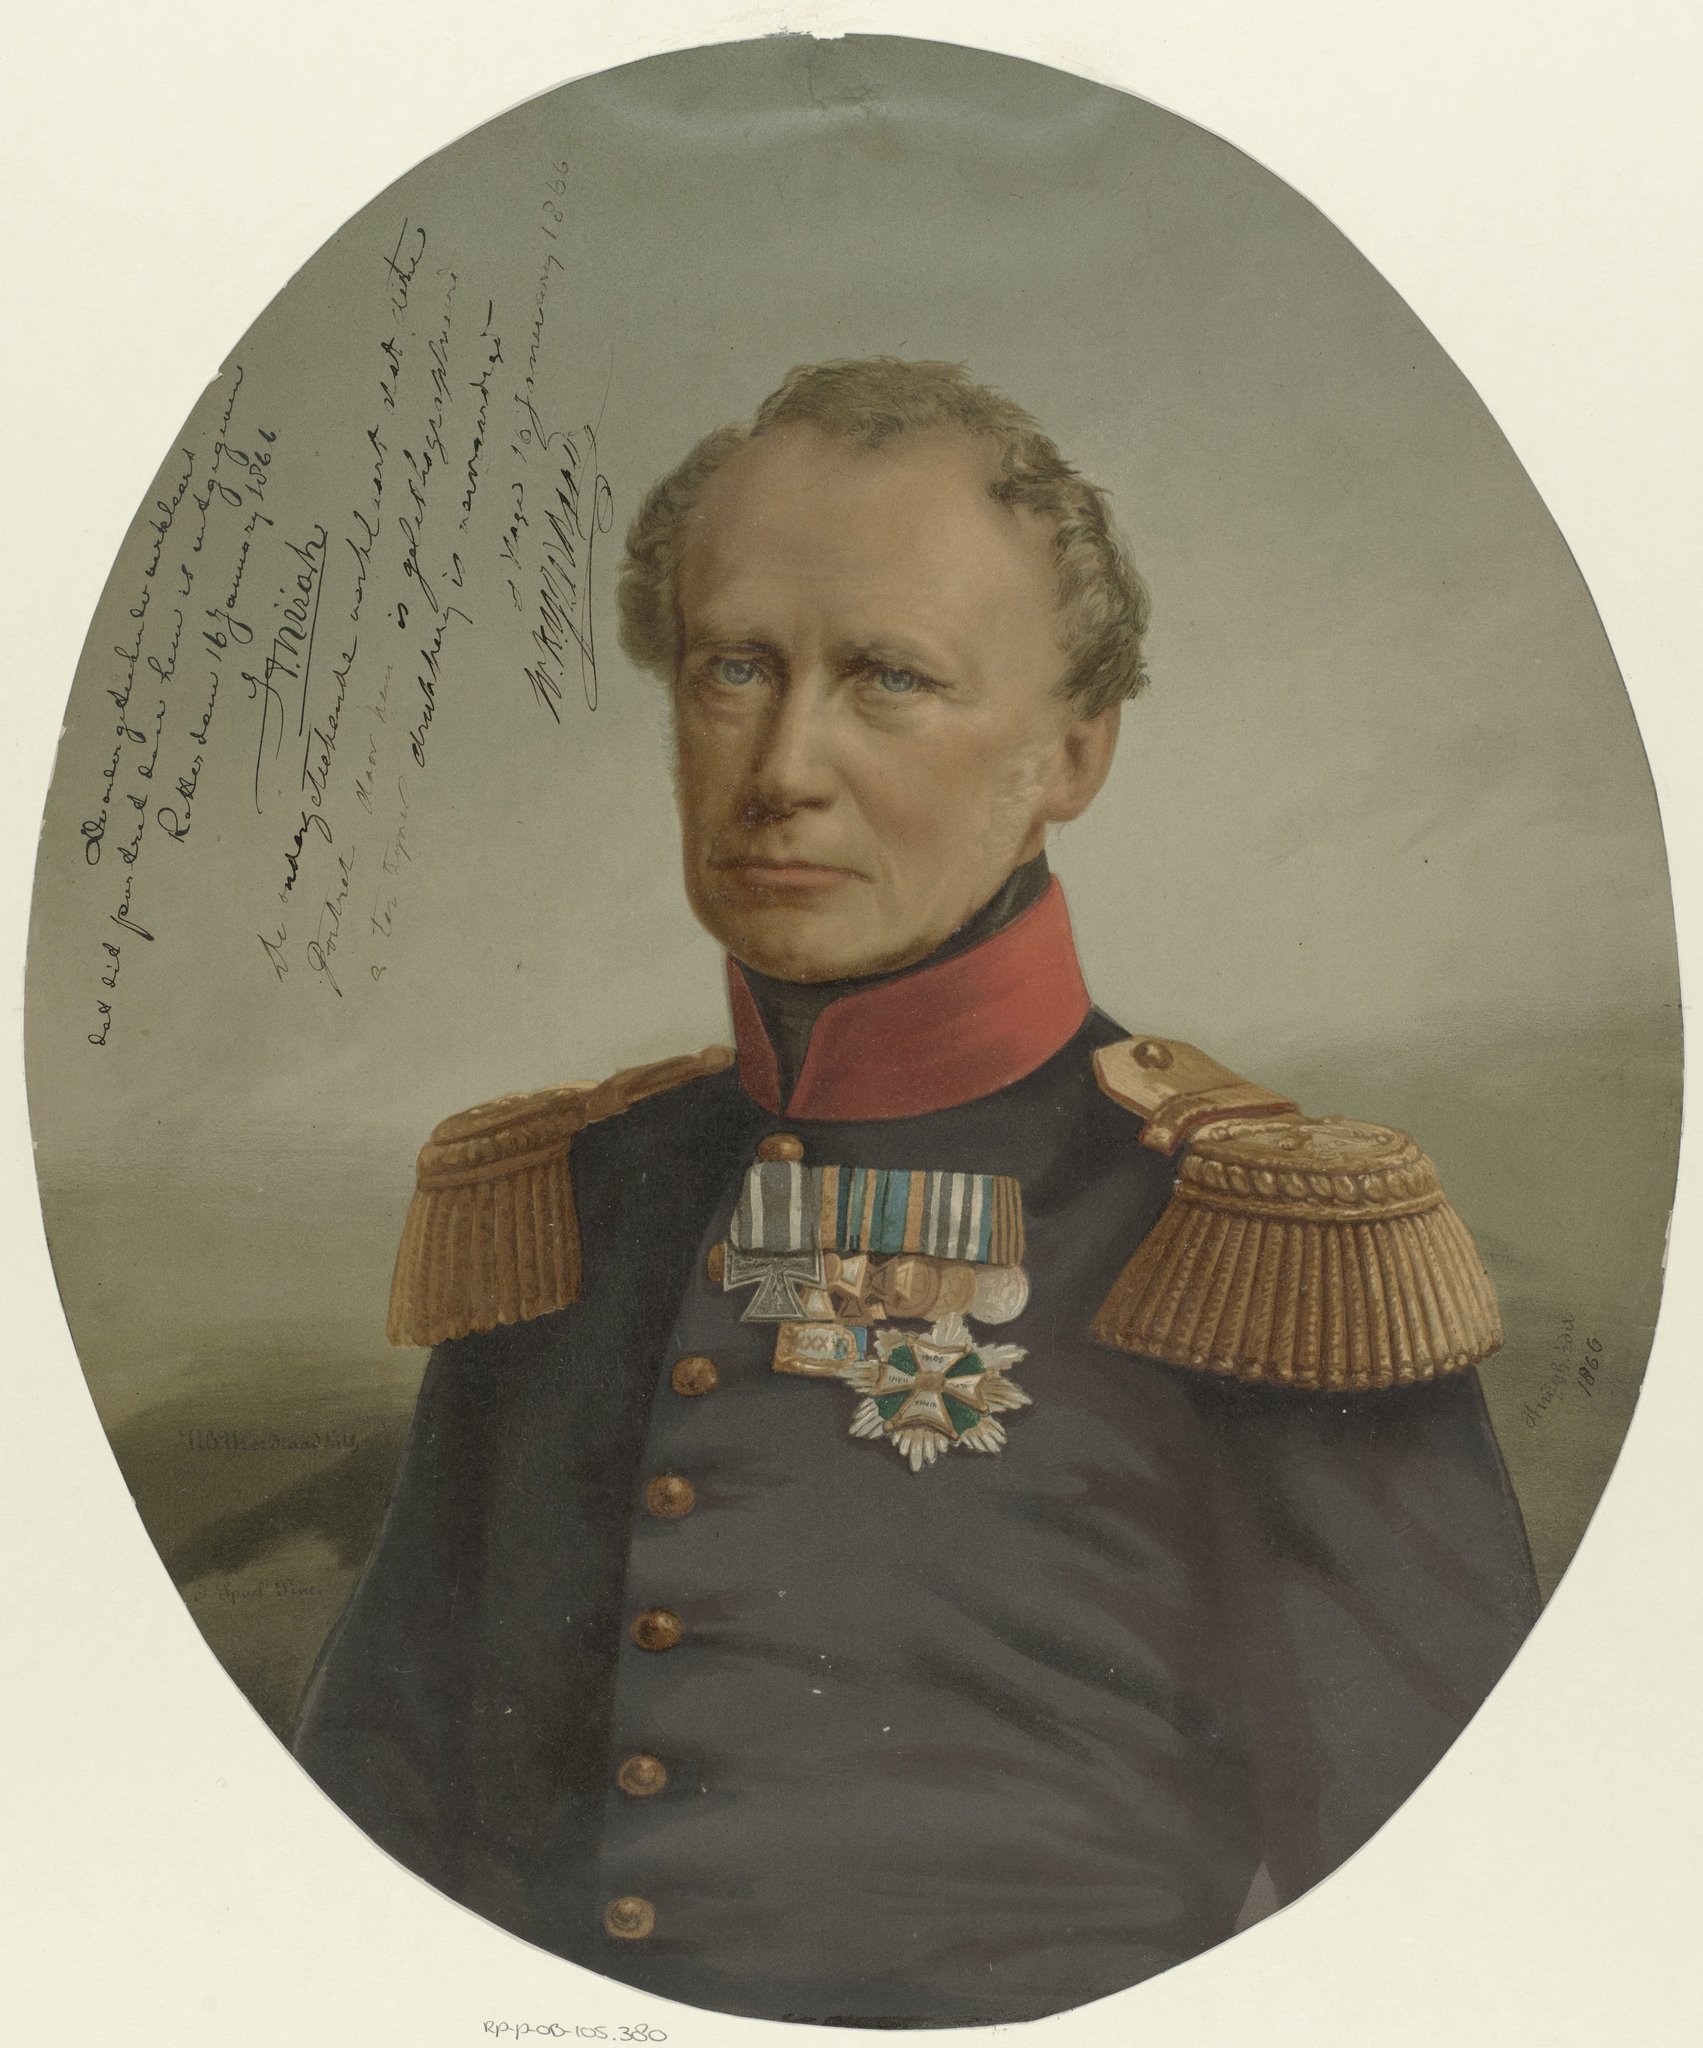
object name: print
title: Portret van Frederik, prins der Nederlanden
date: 1866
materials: paper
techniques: lithograph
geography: netherlands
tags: berlin, frederik (prins der nederlanden)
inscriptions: : ‘De ondergeteekende verklaart dat dit portret door hem is gelithographeerd en ter zijner drukkery is vervaardigd. s Hage 16 January 1866 W.B. Yzerdraad’, : ‘De onder geteekende verklaart dat dit portret door hem is uitgegeven. Rotterdam 16 January 1866 H. Nijgh’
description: De hier vermelde titel verwijst naar de hoogst verkregen titel van de geportretteerde, niet per se naar de titel die de geportretteerde op deze voorstelling draagt.